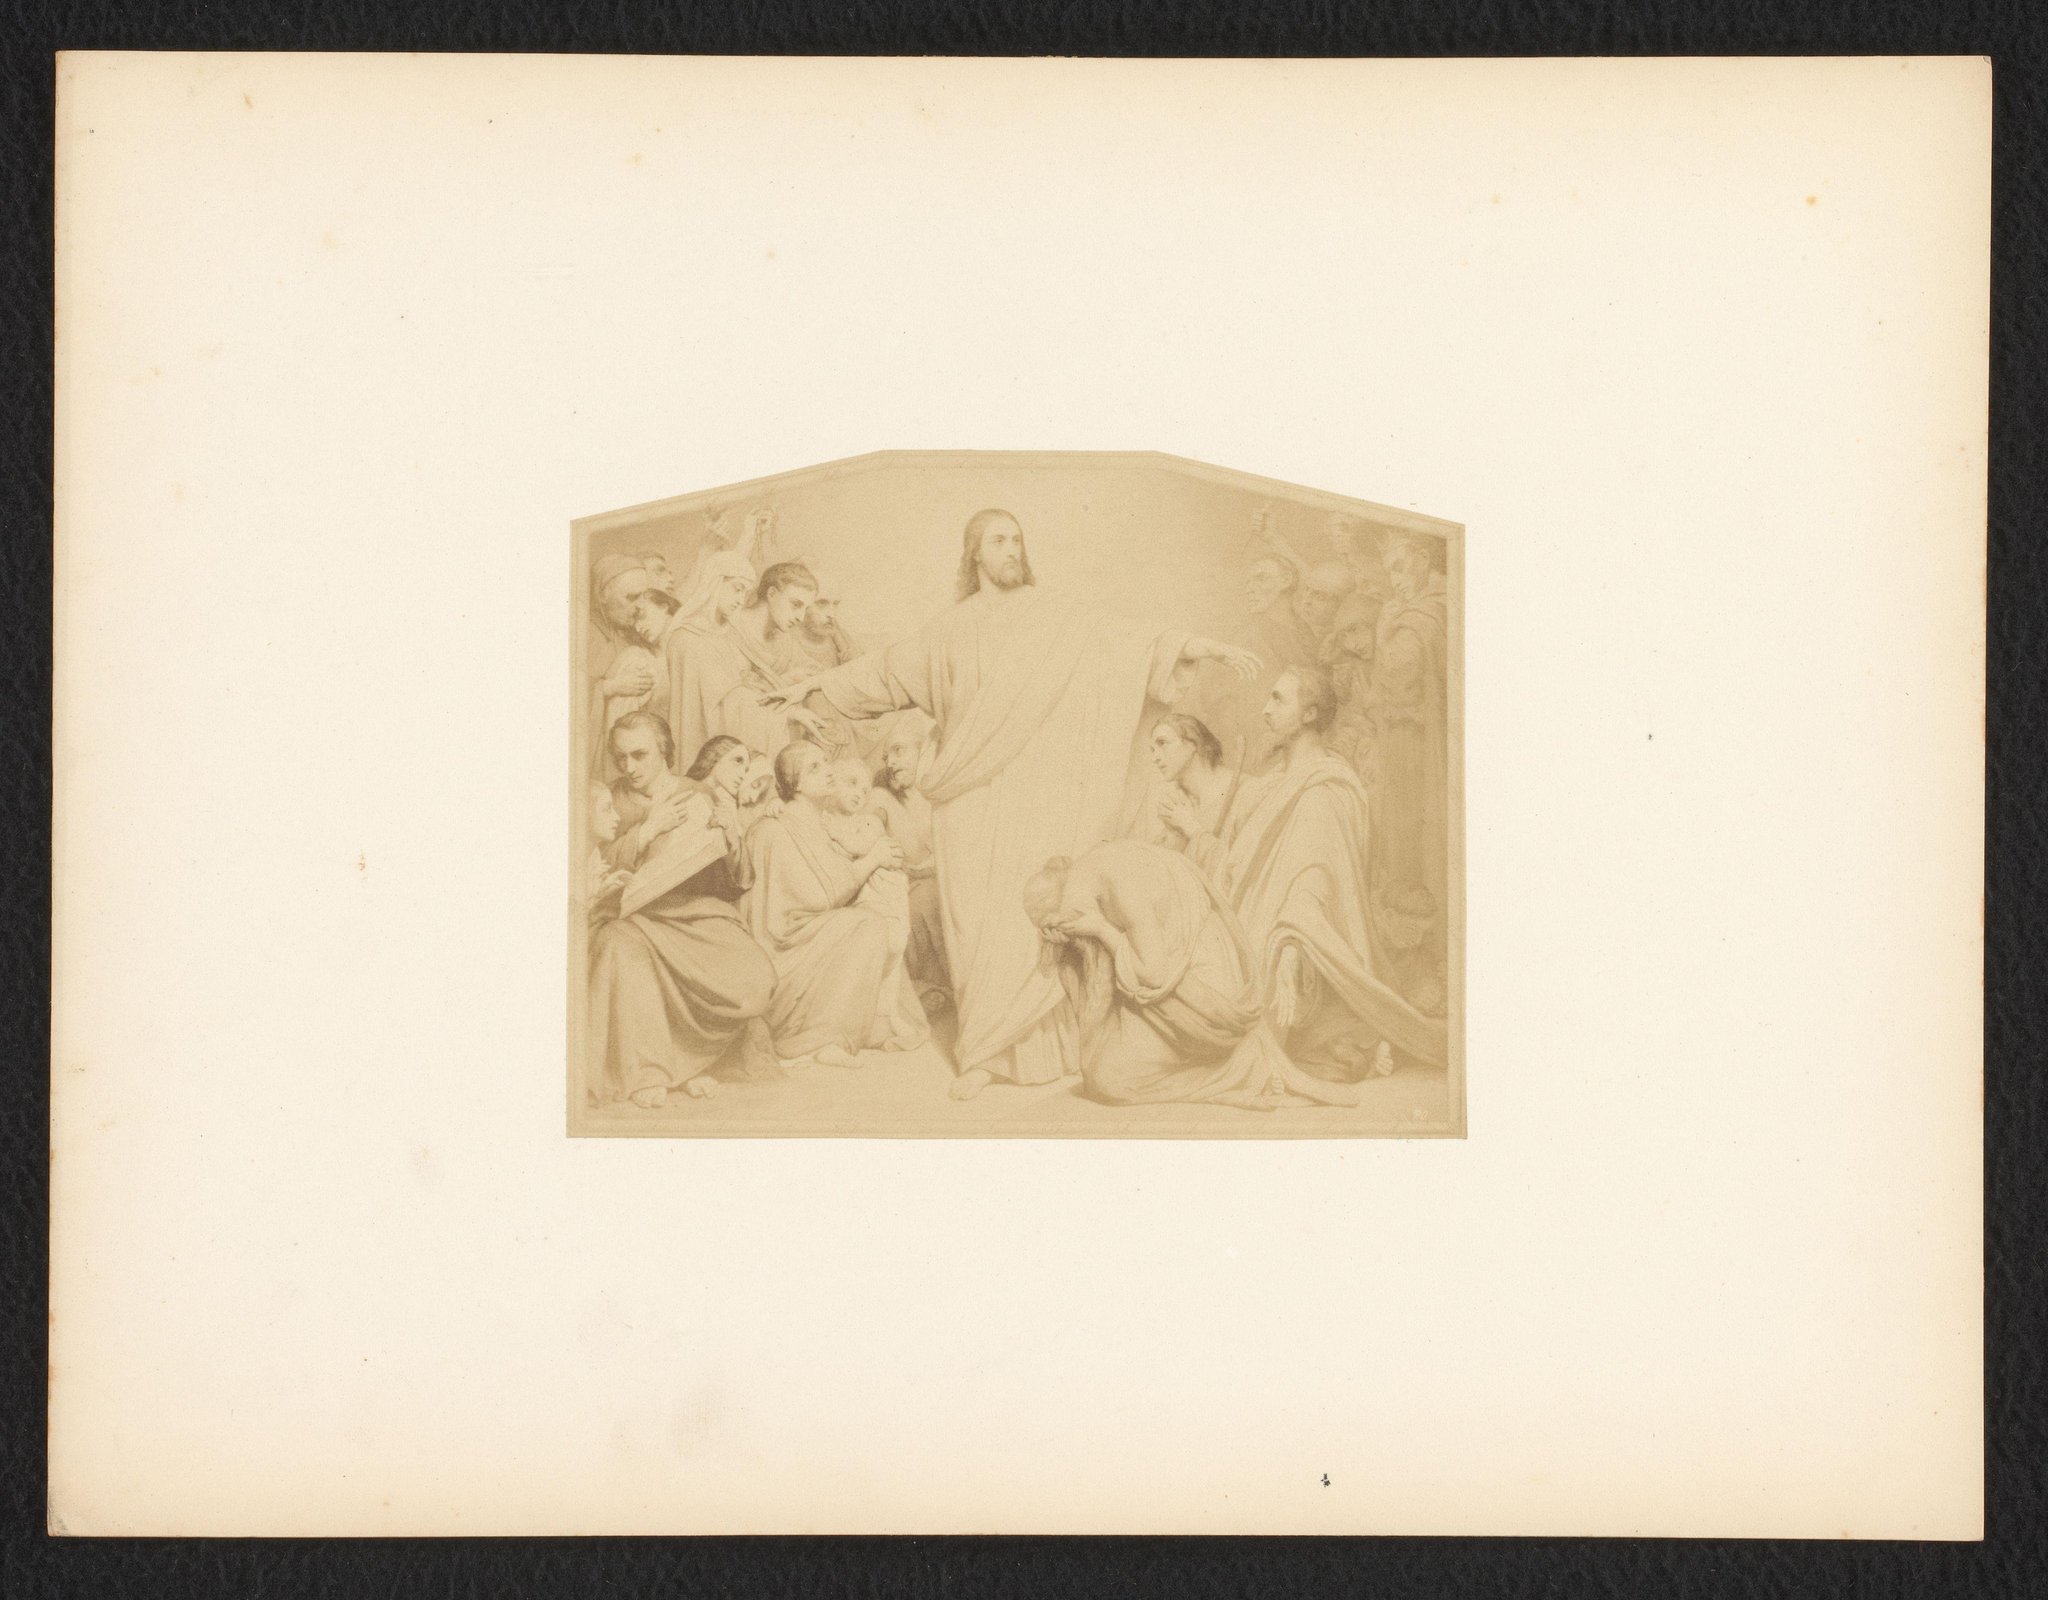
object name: reproduction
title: Fotoreproductie van het schilderij Christus Remunerator naar A. Scheffer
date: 1860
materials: cardboard, paper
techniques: albumen print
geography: amsterdam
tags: picture, painting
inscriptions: monogram: ‘P.O.’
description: Deze foto maakt deel uit van een omslag.